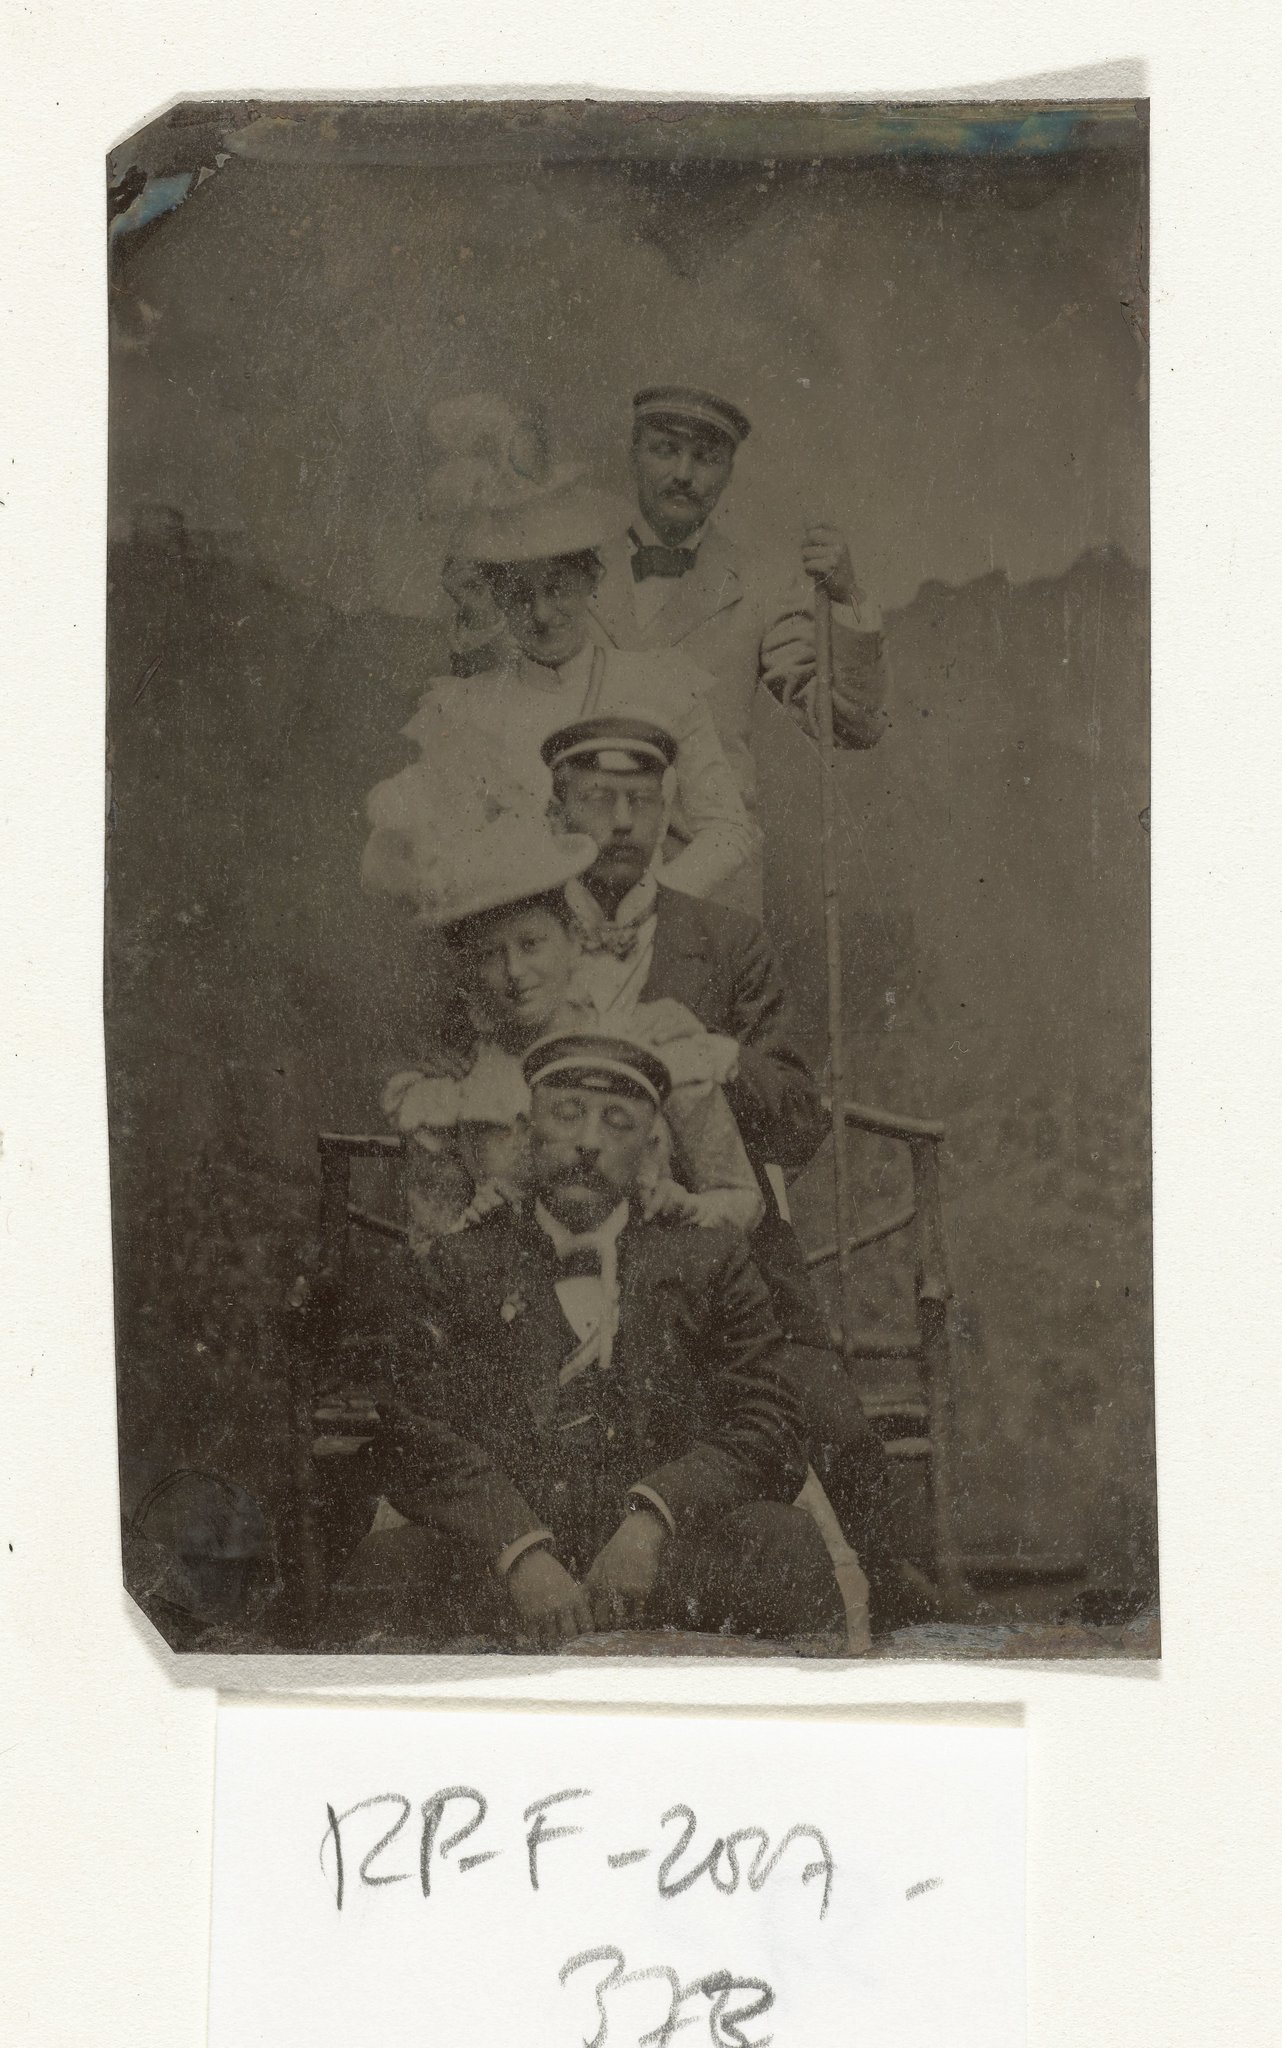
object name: photograph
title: Groepsportret van drie mannen en twee vrouwen, staand en zittend voor een geschilderd achtergronddoek (berg met kasteel) (Duitsland?)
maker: Anonymous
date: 1880-1910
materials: metal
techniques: ferrotyping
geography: germany